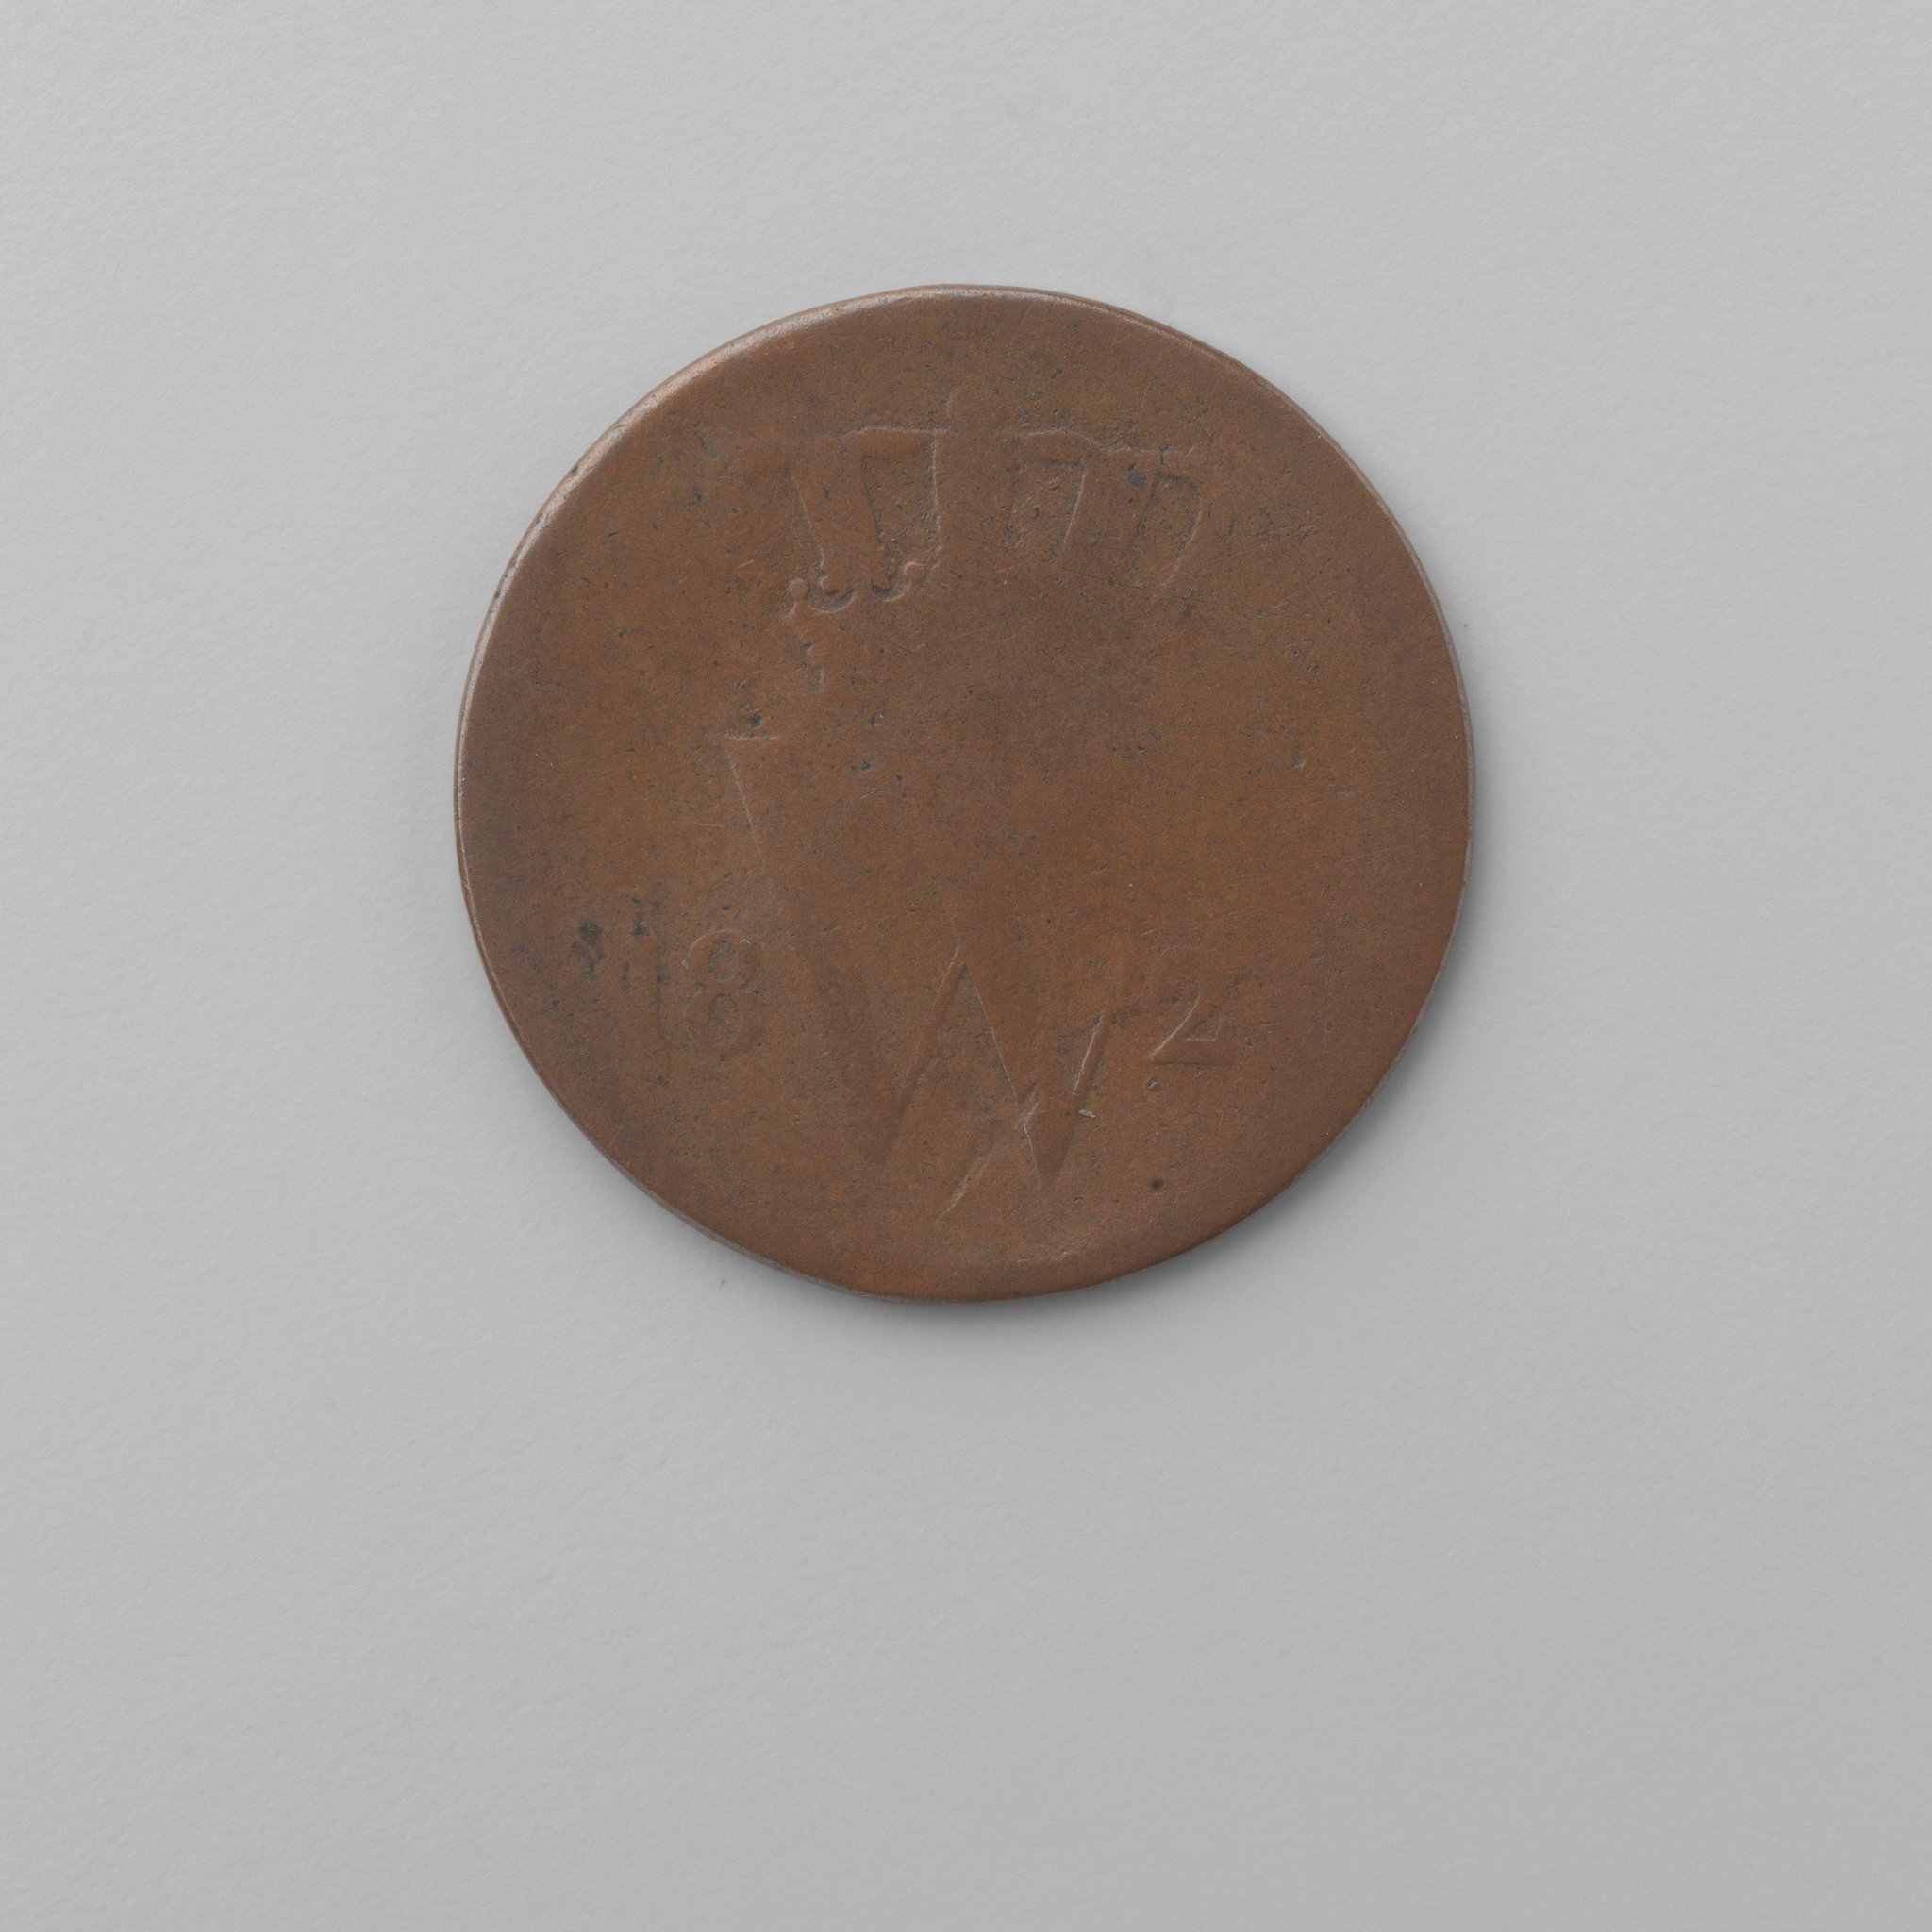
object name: coin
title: Nederland, cent, 1821 B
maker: william i of the netherlands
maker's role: koning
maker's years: 1772-1843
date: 1821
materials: copper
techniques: striking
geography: brussels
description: Koperen munt. Voorzijde: tussen jaartal gekroonde rechte letter W. Keerzijde: tussen waarde-aanduiding 1 C. gekroond rijkswapenschild. Gladde rand.